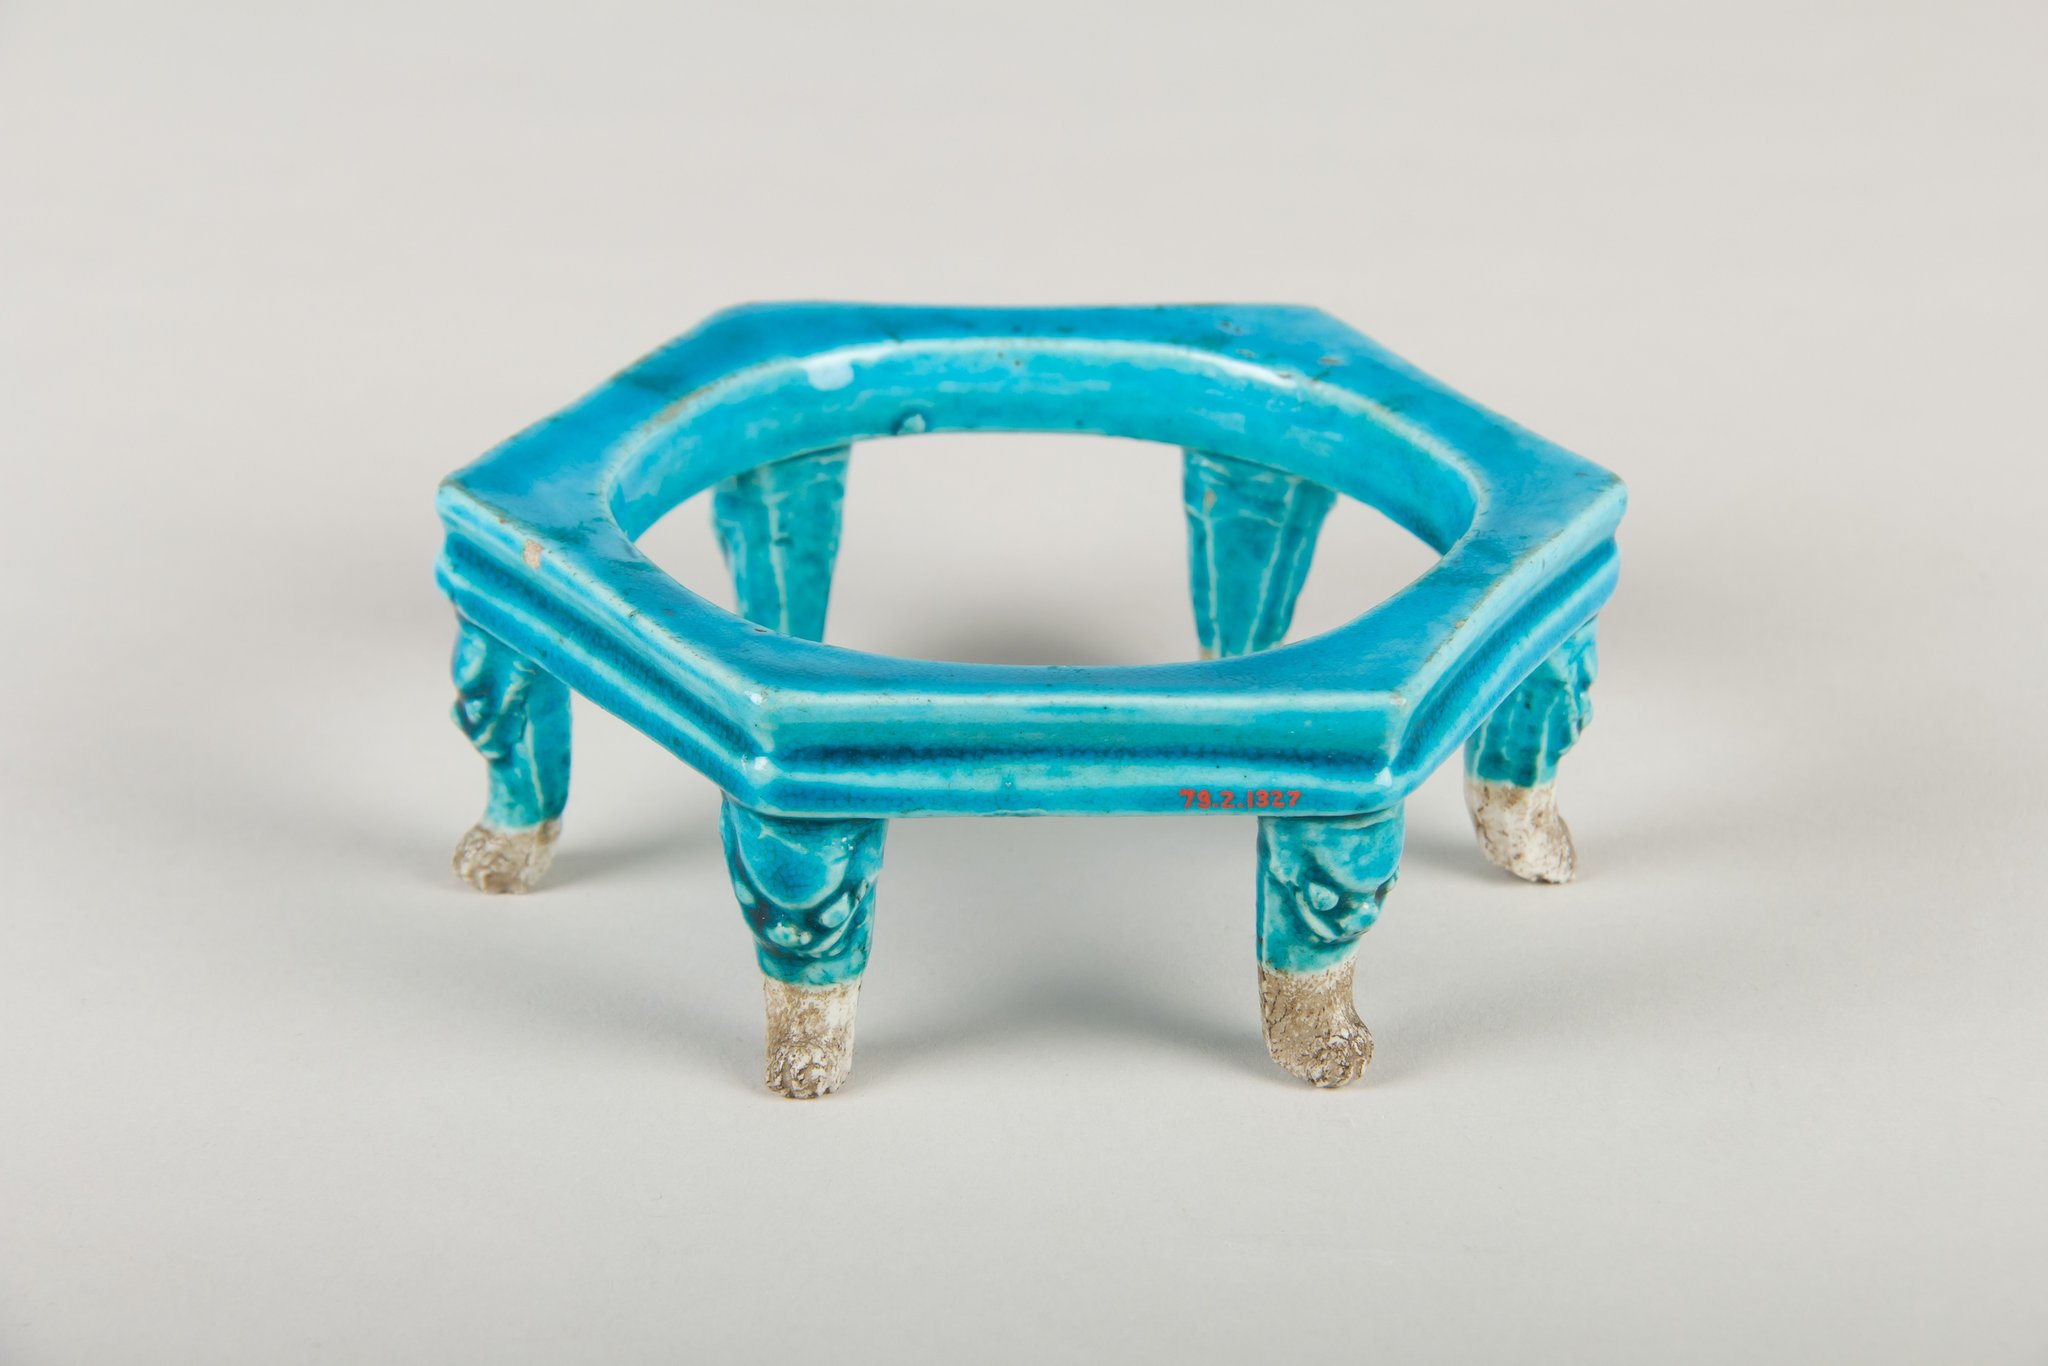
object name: stand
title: Hexagonal stand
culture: chinese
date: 1667-1733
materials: glaze, porcelain